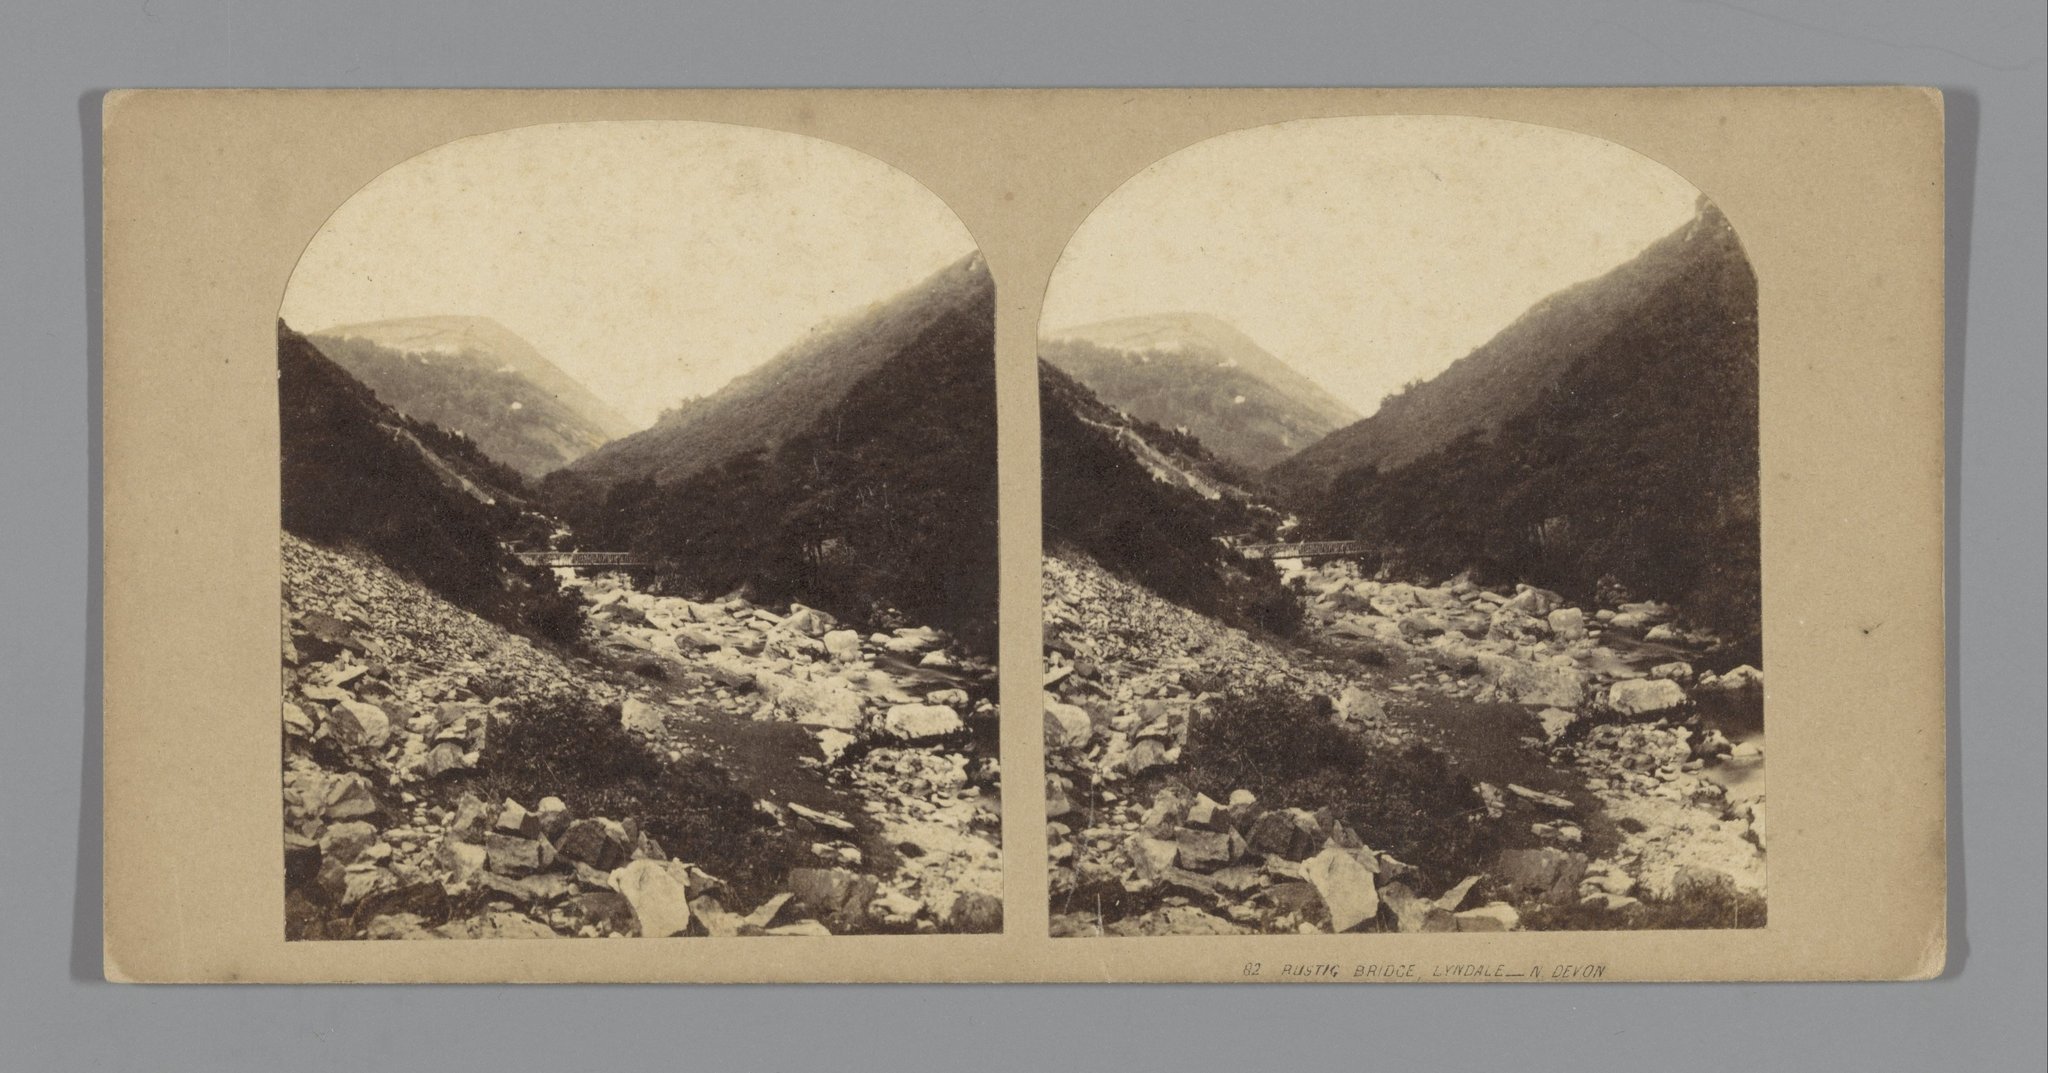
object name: stereograph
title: Rustic Bridge, Lyndale-N.Devon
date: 1850-1880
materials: cardboard, photographic support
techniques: albumen print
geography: devon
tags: river, landscape with bridge, viaduct or aqueduct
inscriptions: number: ‘82.’, inscription: ‘Stereoscopic Treasures’, name: ‘Published by W. Spreat. 229 High Street. Exeter.’